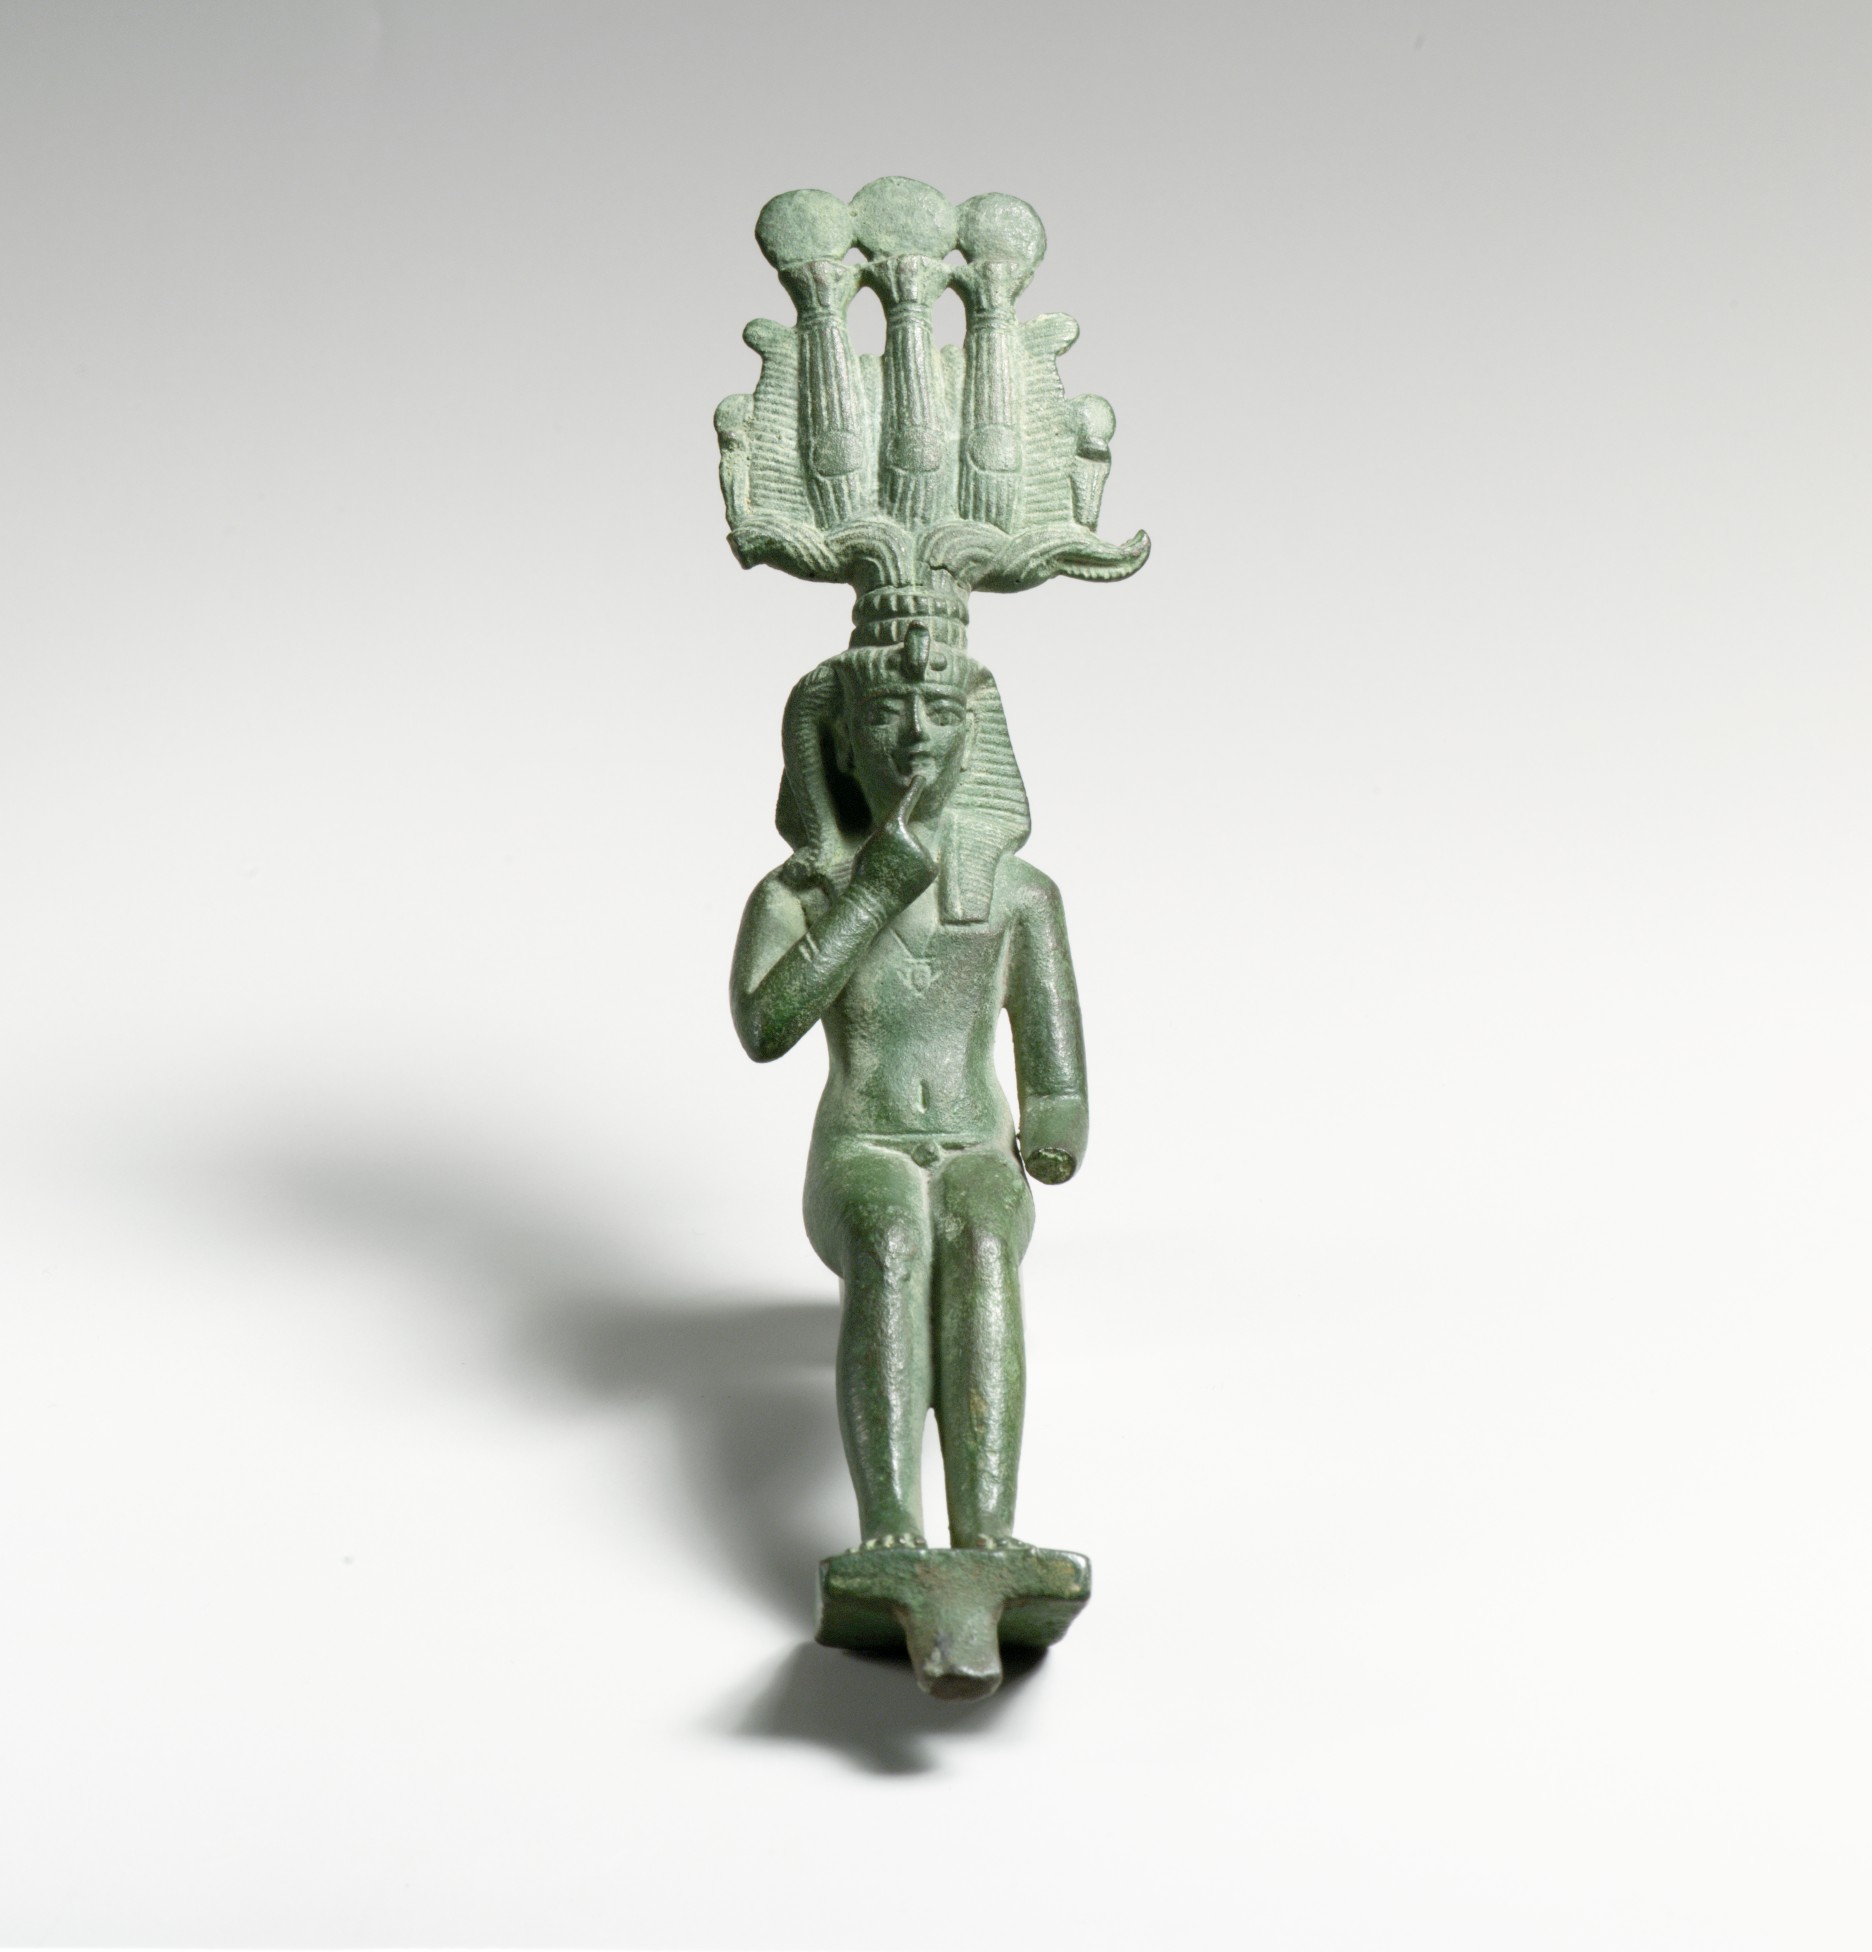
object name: statuette of horus a an infant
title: Bronze statuette of Horus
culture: egyptian, ptolemaic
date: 304-30 BCE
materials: bronze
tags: horus